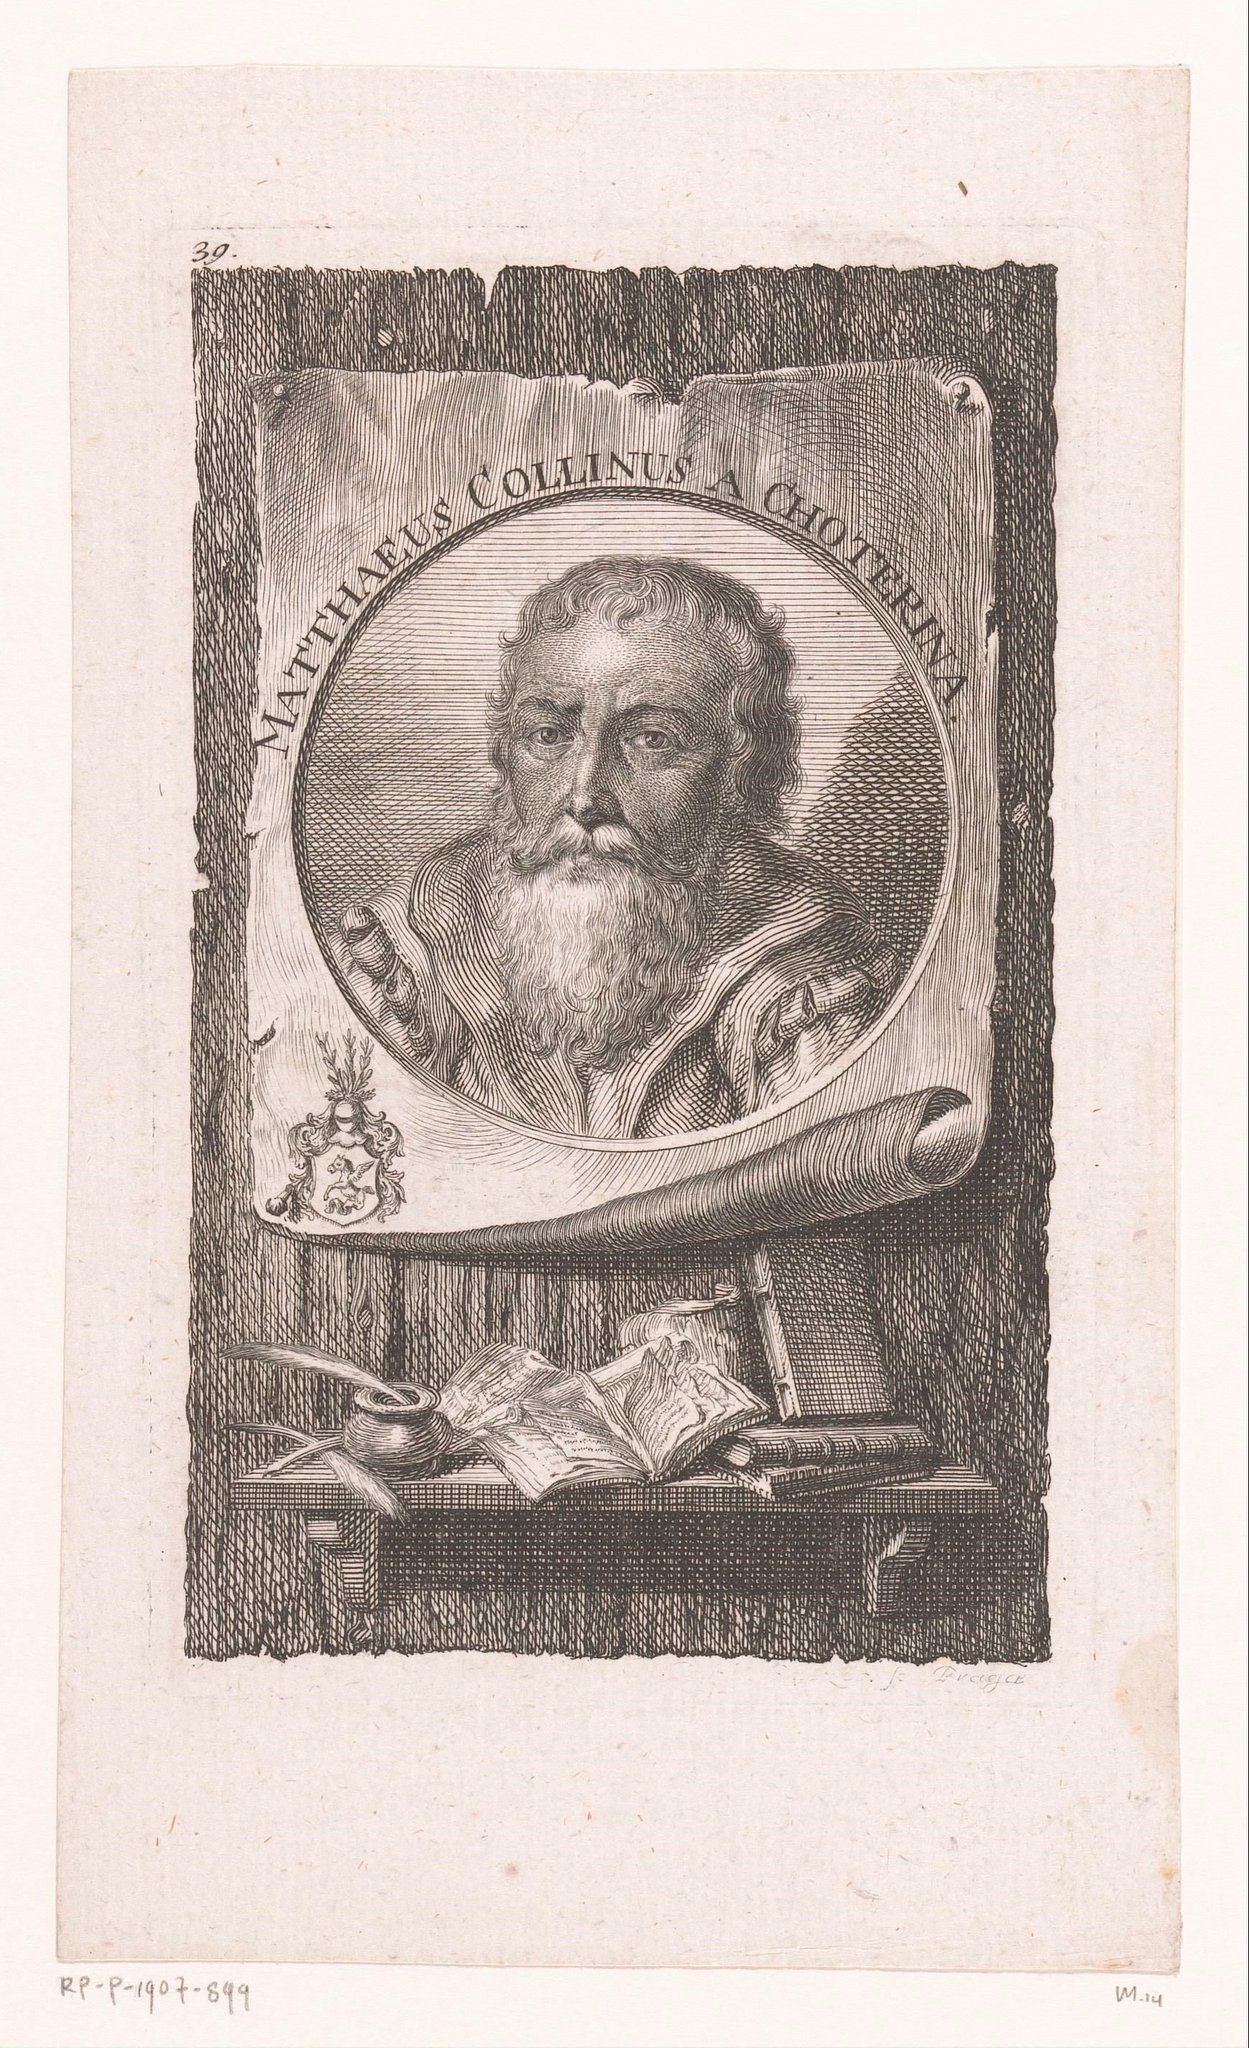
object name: print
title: Matthaeus Collinus a Choterina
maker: jan balzer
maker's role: print maker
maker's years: 1736-1799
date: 1746-1799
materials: paper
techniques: engraving, etching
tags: prague, historical persons, writer, poet, author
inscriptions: collector's mark: Lugt 2228